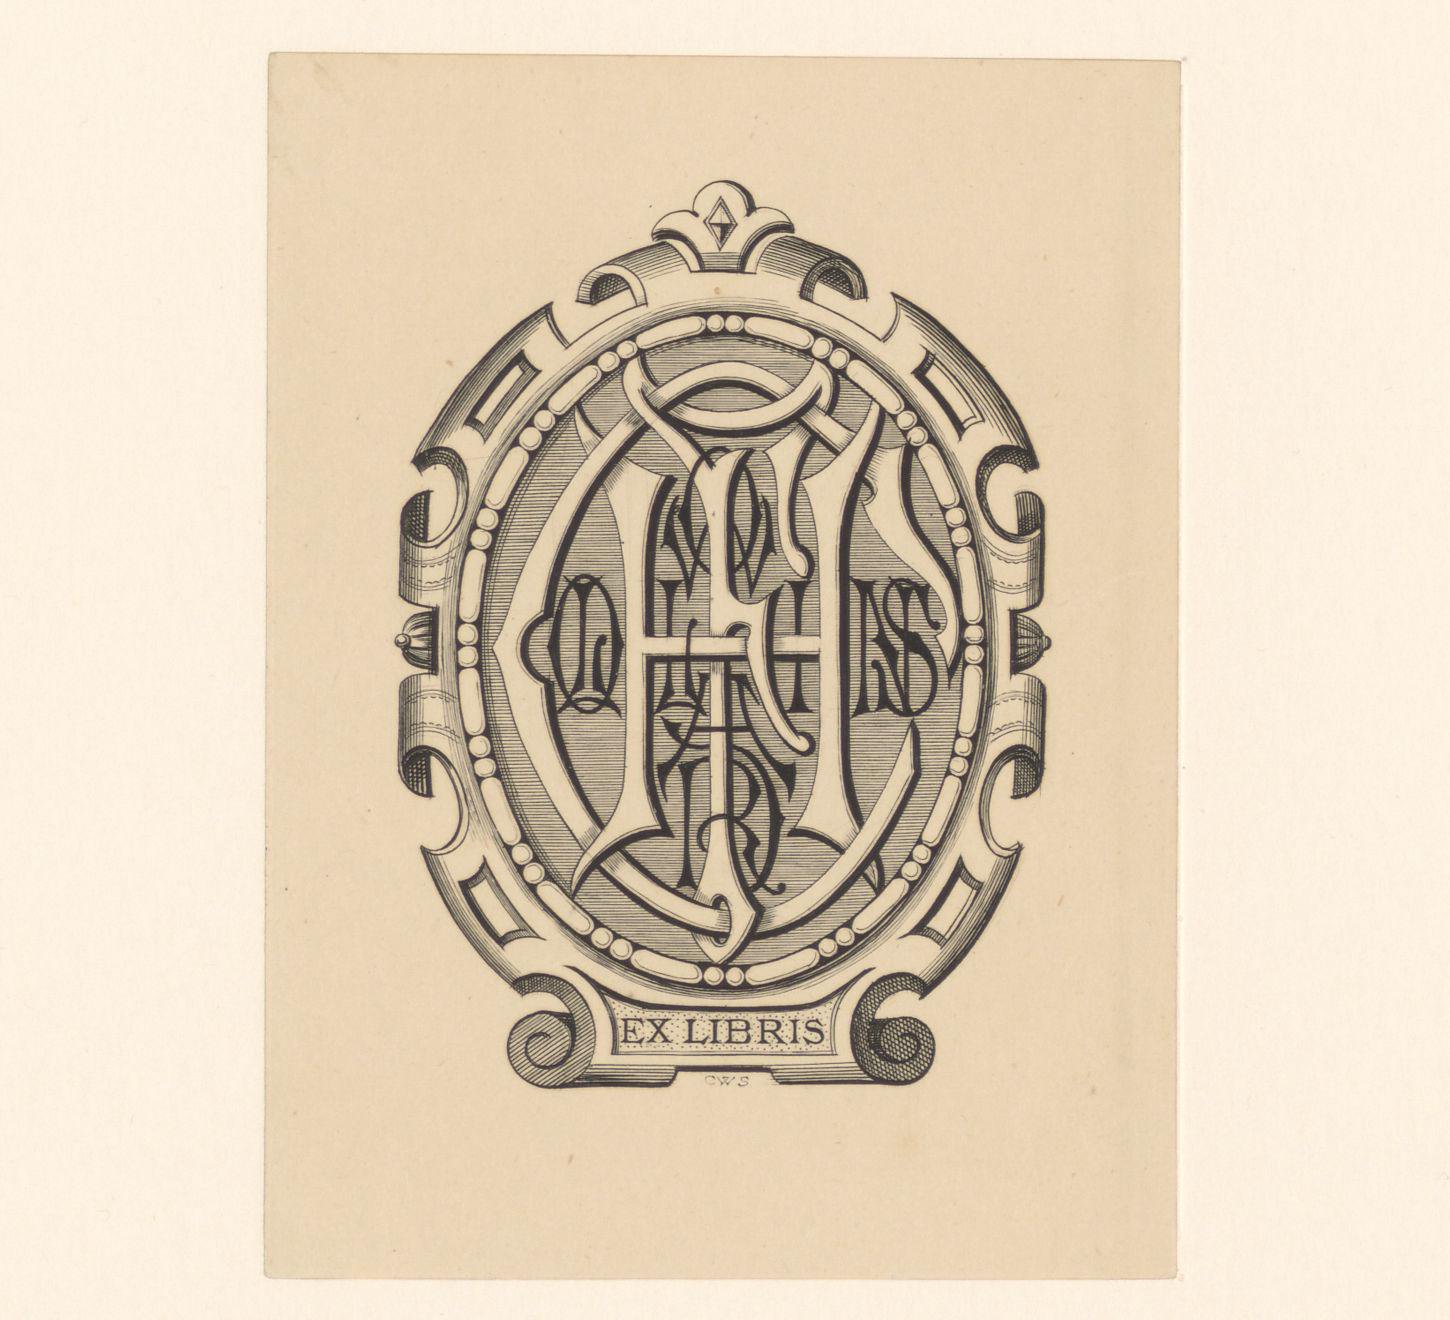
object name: bookplate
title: Ex libris van onbekend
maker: charles william sherborn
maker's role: print maker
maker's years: 1831-1912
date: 1841-1912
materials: paper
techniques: engraving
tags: ex-libris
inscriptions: collector's mark: Lugt 2228